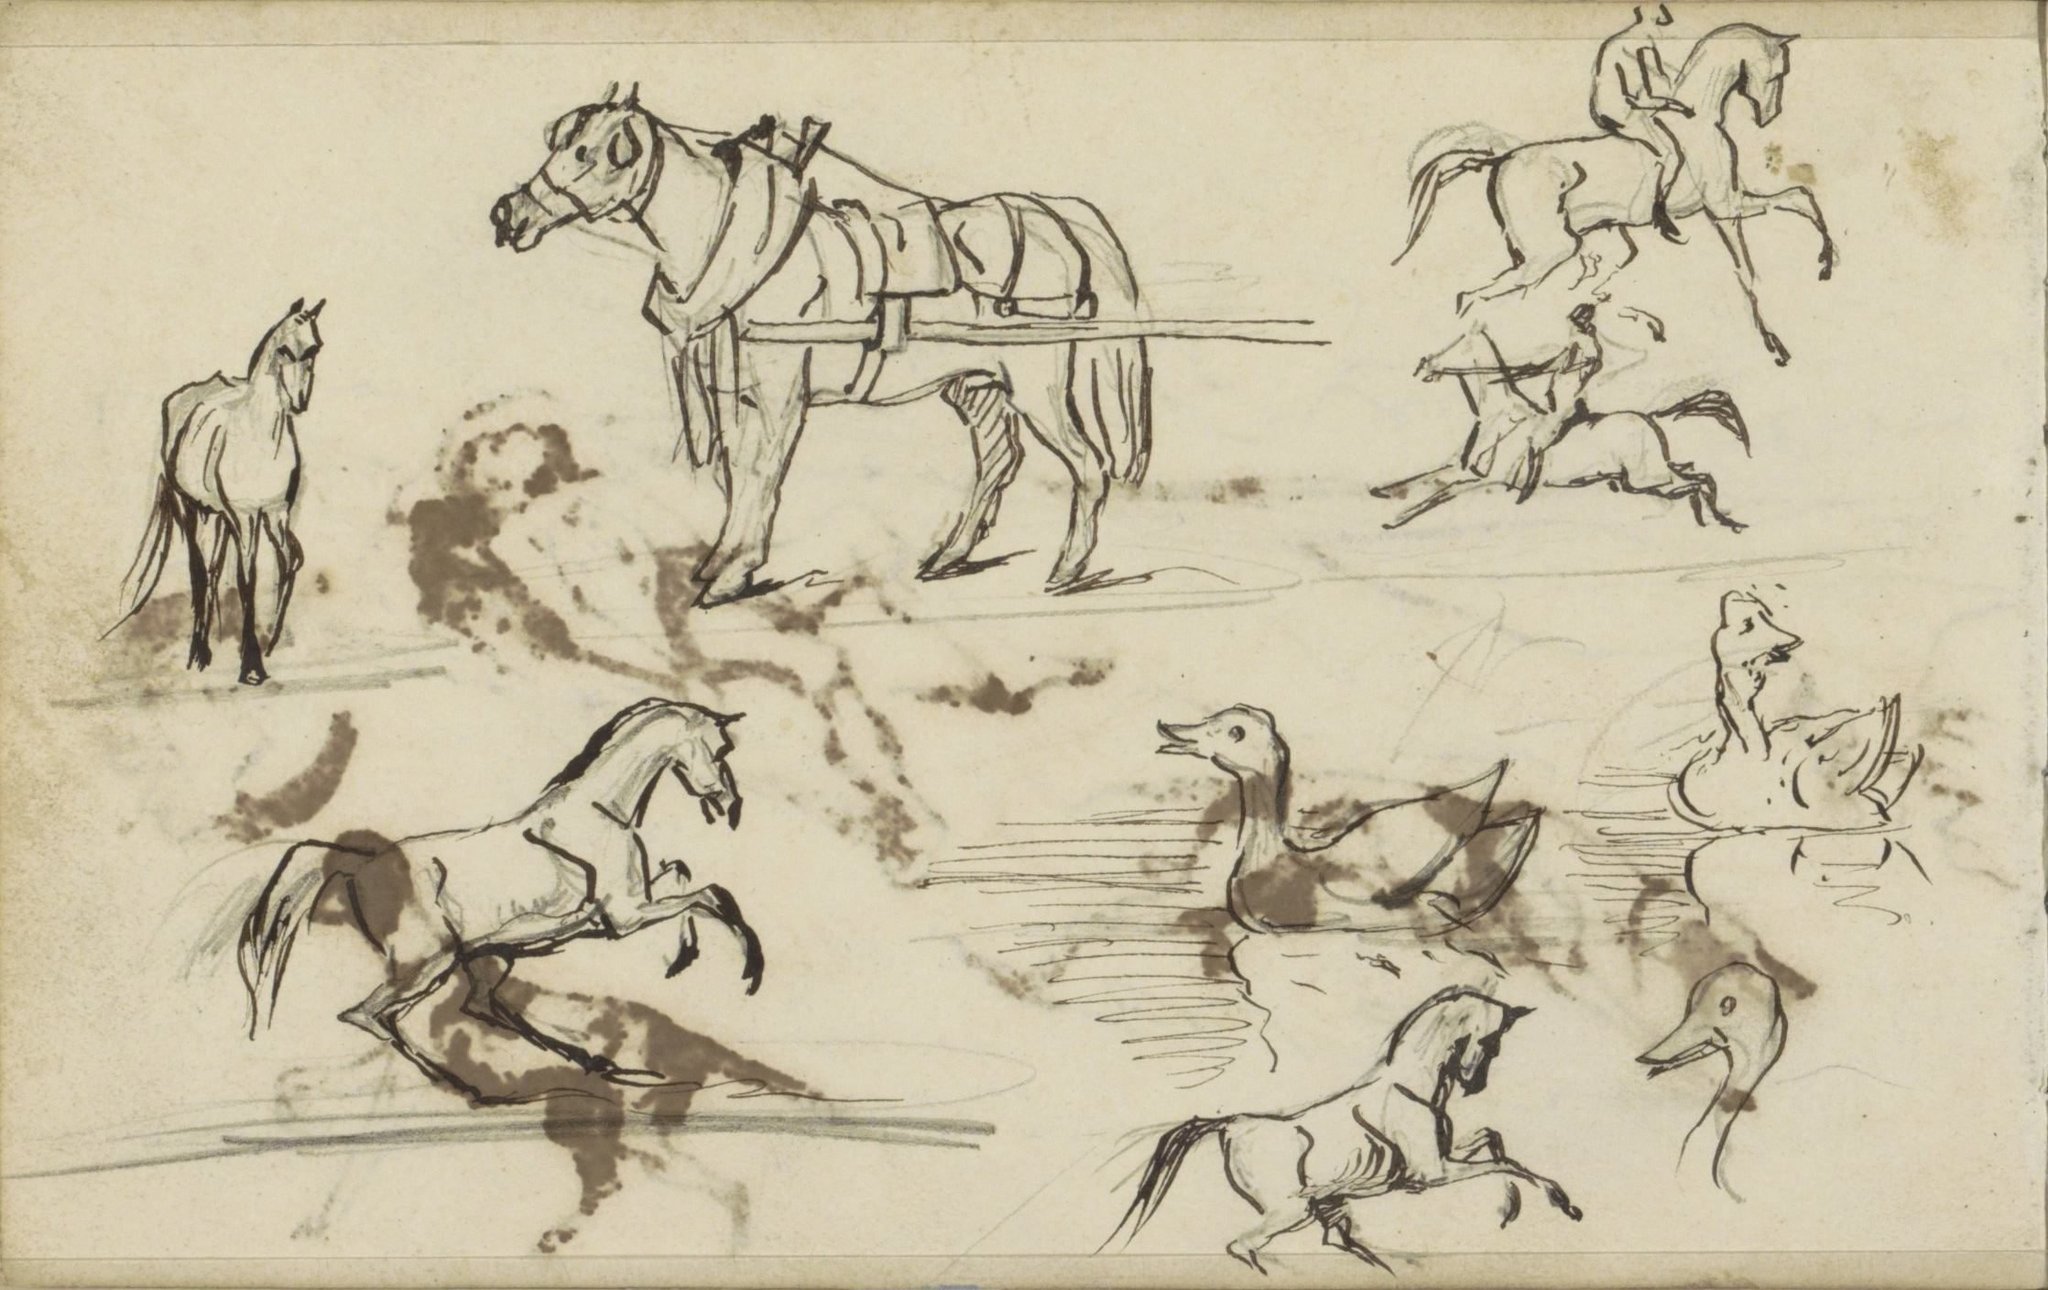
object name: sketchbook leaf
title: Studieblad met ruiters, paarden en eenden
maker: johannes tavenraat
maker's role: draughtsman, painter, print maker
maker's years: 1809-1881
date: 1839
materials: paper, pencil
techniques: pen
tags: riding a horse, ass, or mule; rider, horseman, ducks (domestic waterbirds), horse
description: Blad 22 verso uit een schetsboek met 37 bladen.